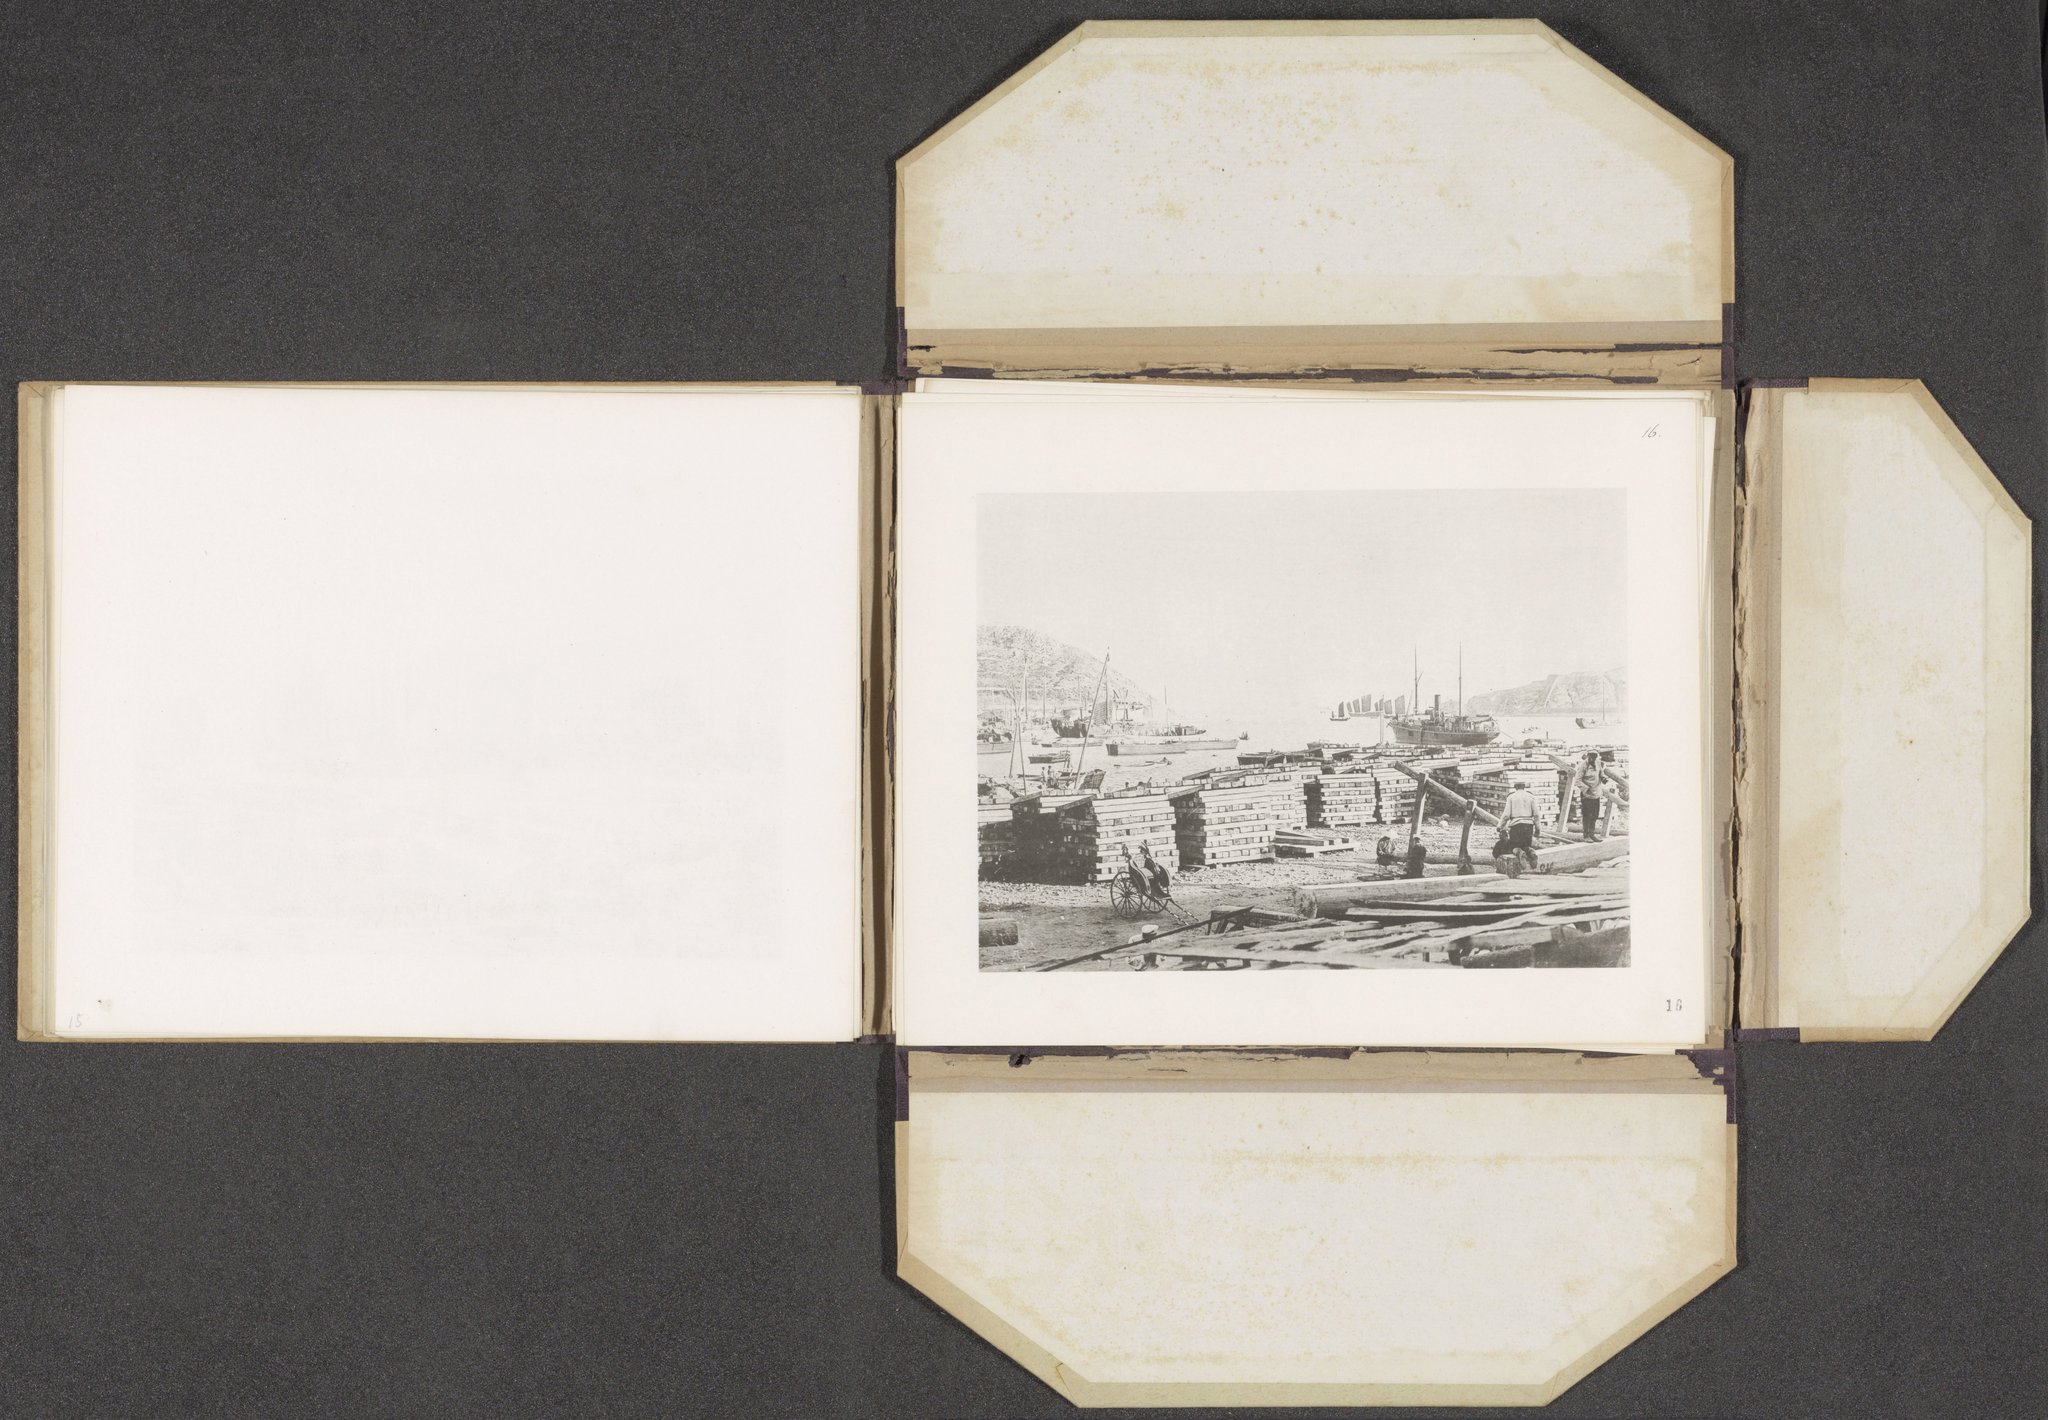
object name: photomechanical print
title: Kade te Port Arthur, met zicht op de baai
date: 1898-1899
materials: paper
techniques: photograph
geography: port arthur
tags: gulf, bay, rickshaw, pier, quay, wharf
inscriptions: number: ‘16’